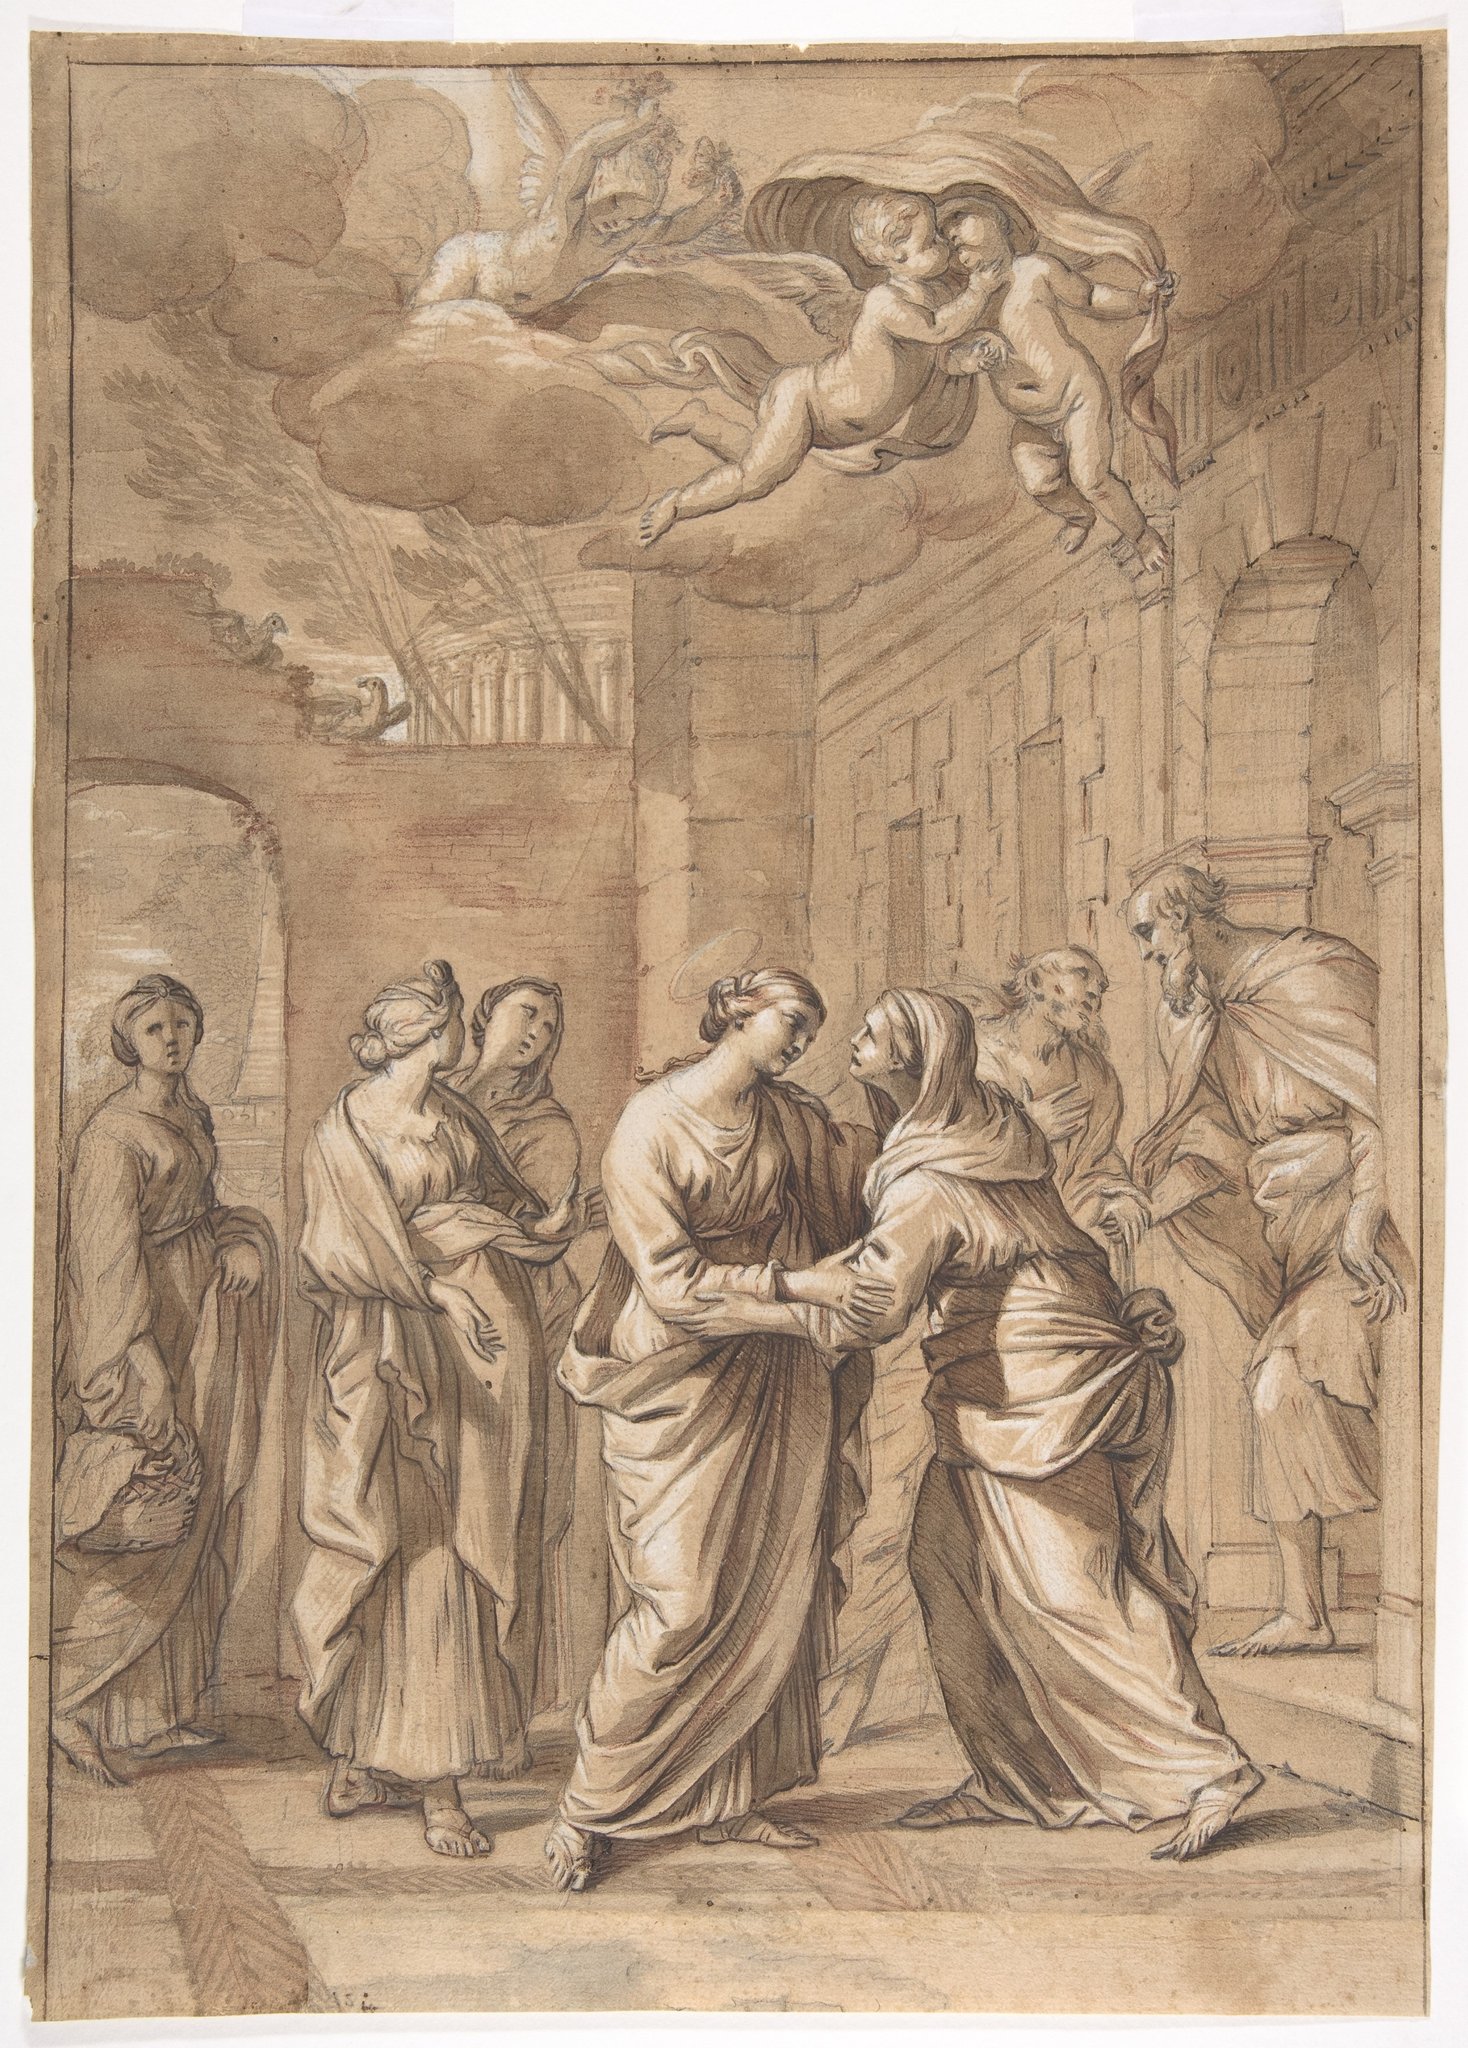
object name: drawing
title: The Visitation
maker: nicolas mignard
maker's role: artist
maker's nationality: french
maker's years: 1606-1668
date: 1649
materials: chalk, gouache, graphite, ink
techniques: brush, heightening, pen, wash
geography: france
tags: men,women,angels,virgin mary